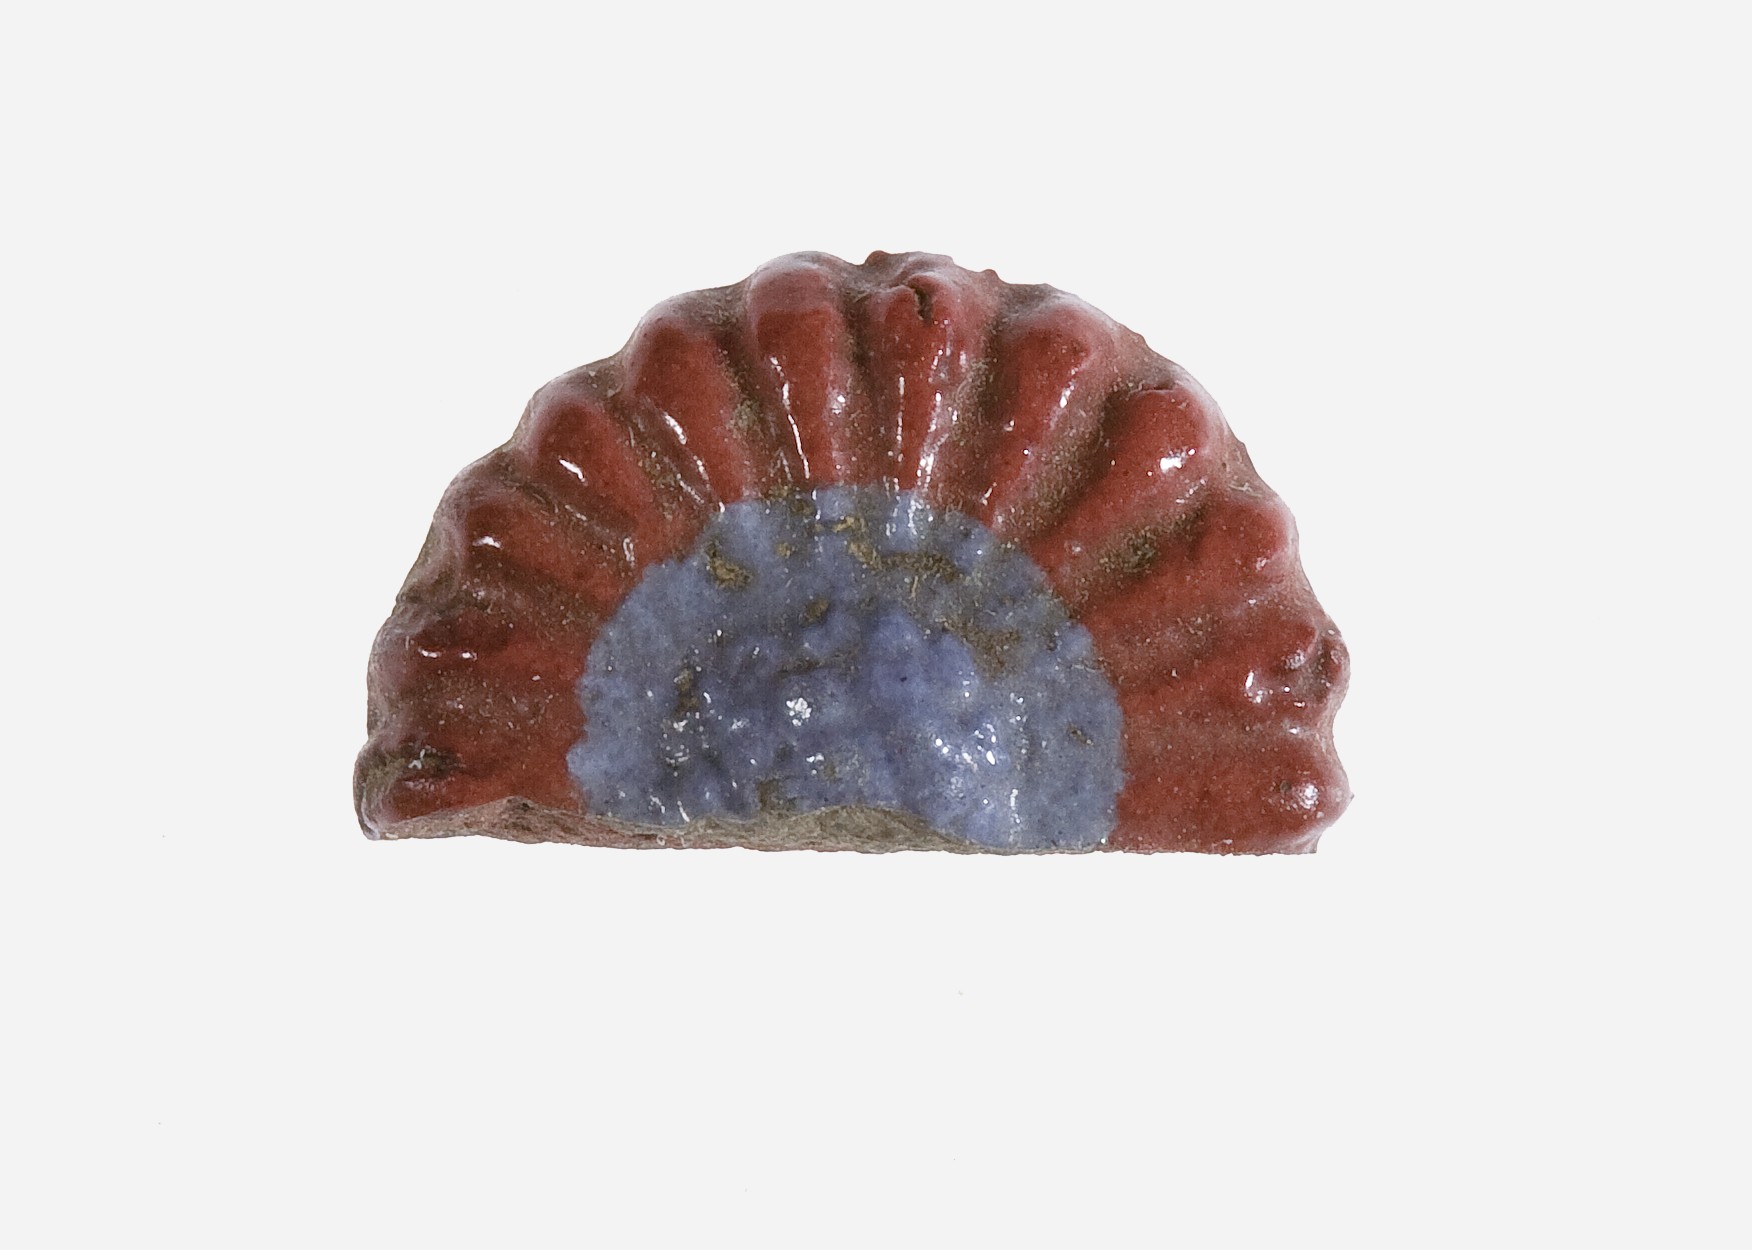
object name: bead, daisy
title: Daisy Bead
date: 1390-1352 BCE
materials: faience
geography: egypt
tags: daisies